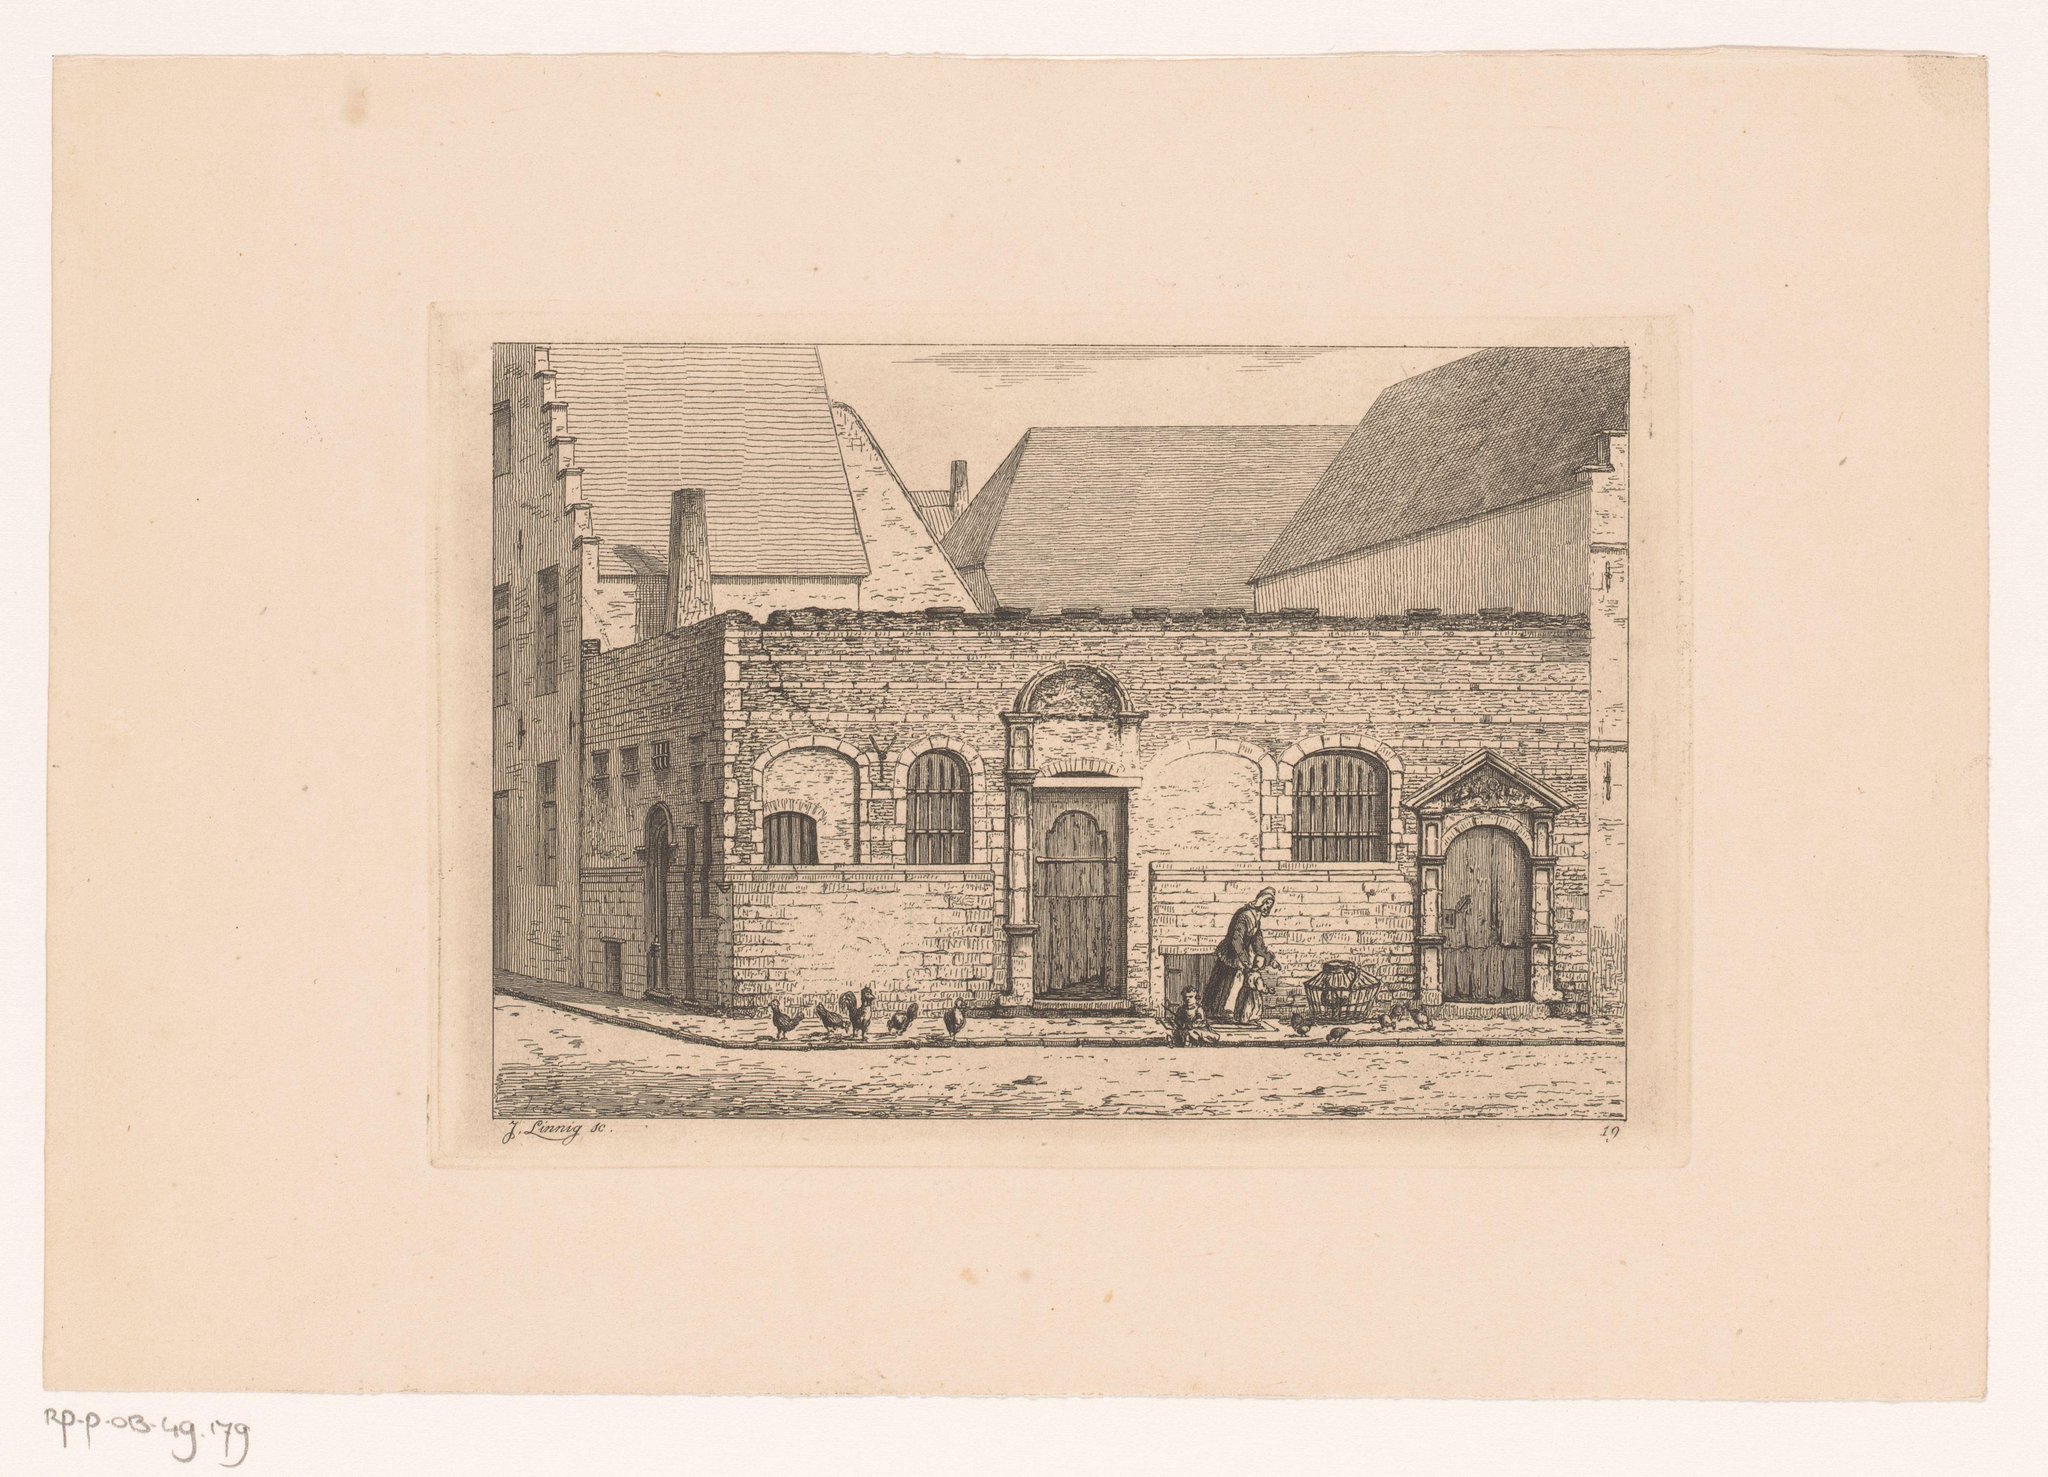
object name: book illustration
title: Gezicht op de Vierschaar in Antwerpen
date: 1868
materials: paper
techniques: etching, intaglio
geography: antwerp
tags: street, antwerp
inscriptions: collector's mark: Lugt 2228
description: Prent uit: Mertens, F.H. Album historique de la ville d'Anvers [...]. Antwerpen: J.E. Buschmann, 1868.